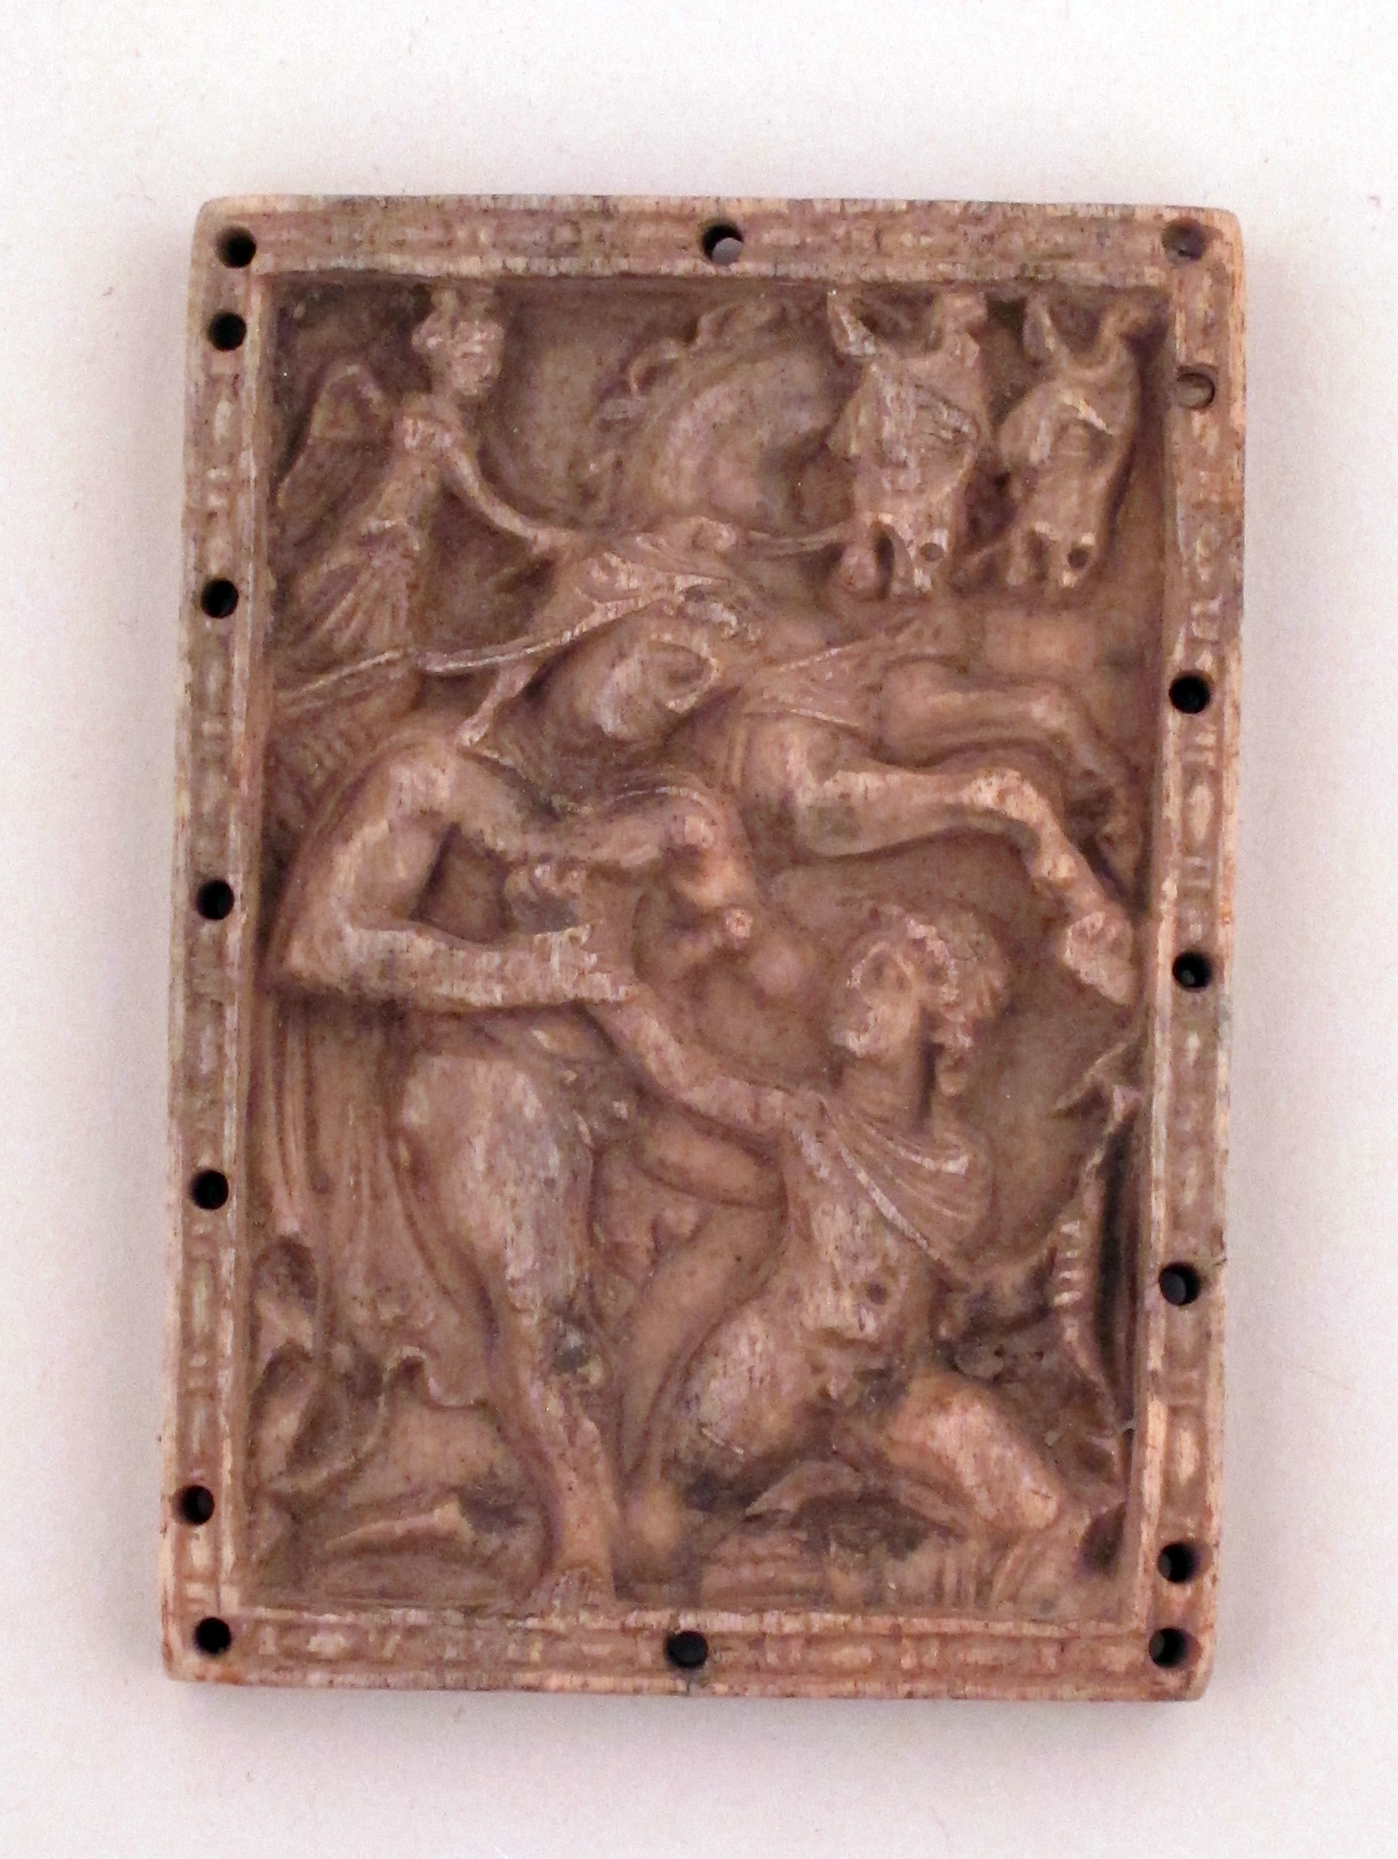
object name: relief of a warrior and nike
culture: roman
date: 201-400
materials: ivory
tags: nike,horses,warriors